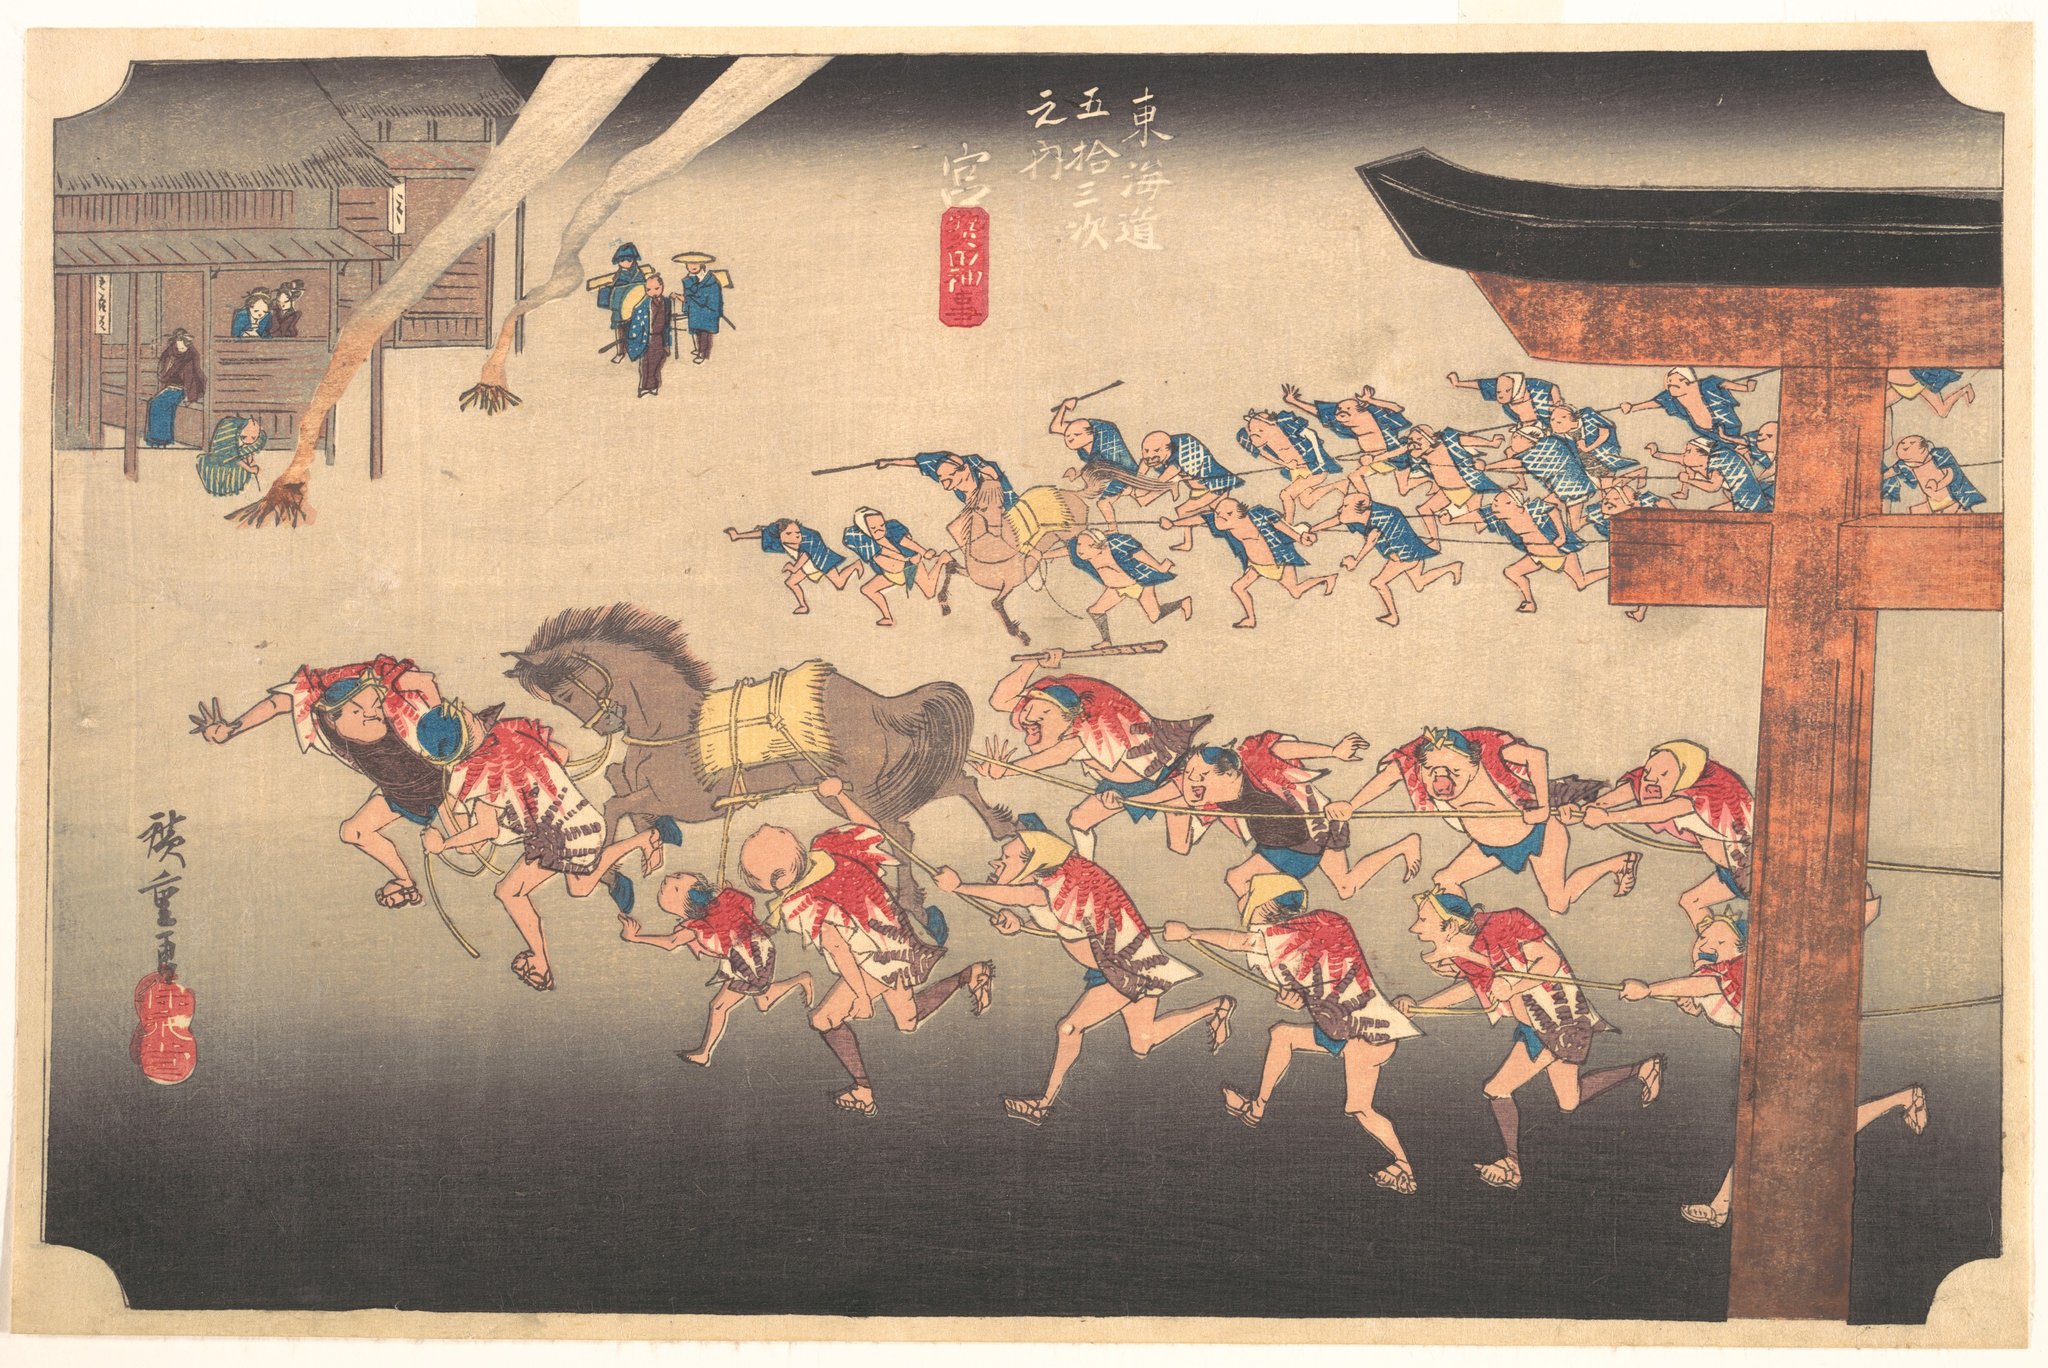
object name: print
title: Festival at Atsuta Temple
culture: japanese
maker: utagawa hiroshige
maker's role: artist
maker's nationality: japanese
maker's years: 1797-1858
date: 1797-1858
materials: ink, paper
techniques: woodblock print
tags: men,running,horses,shintō